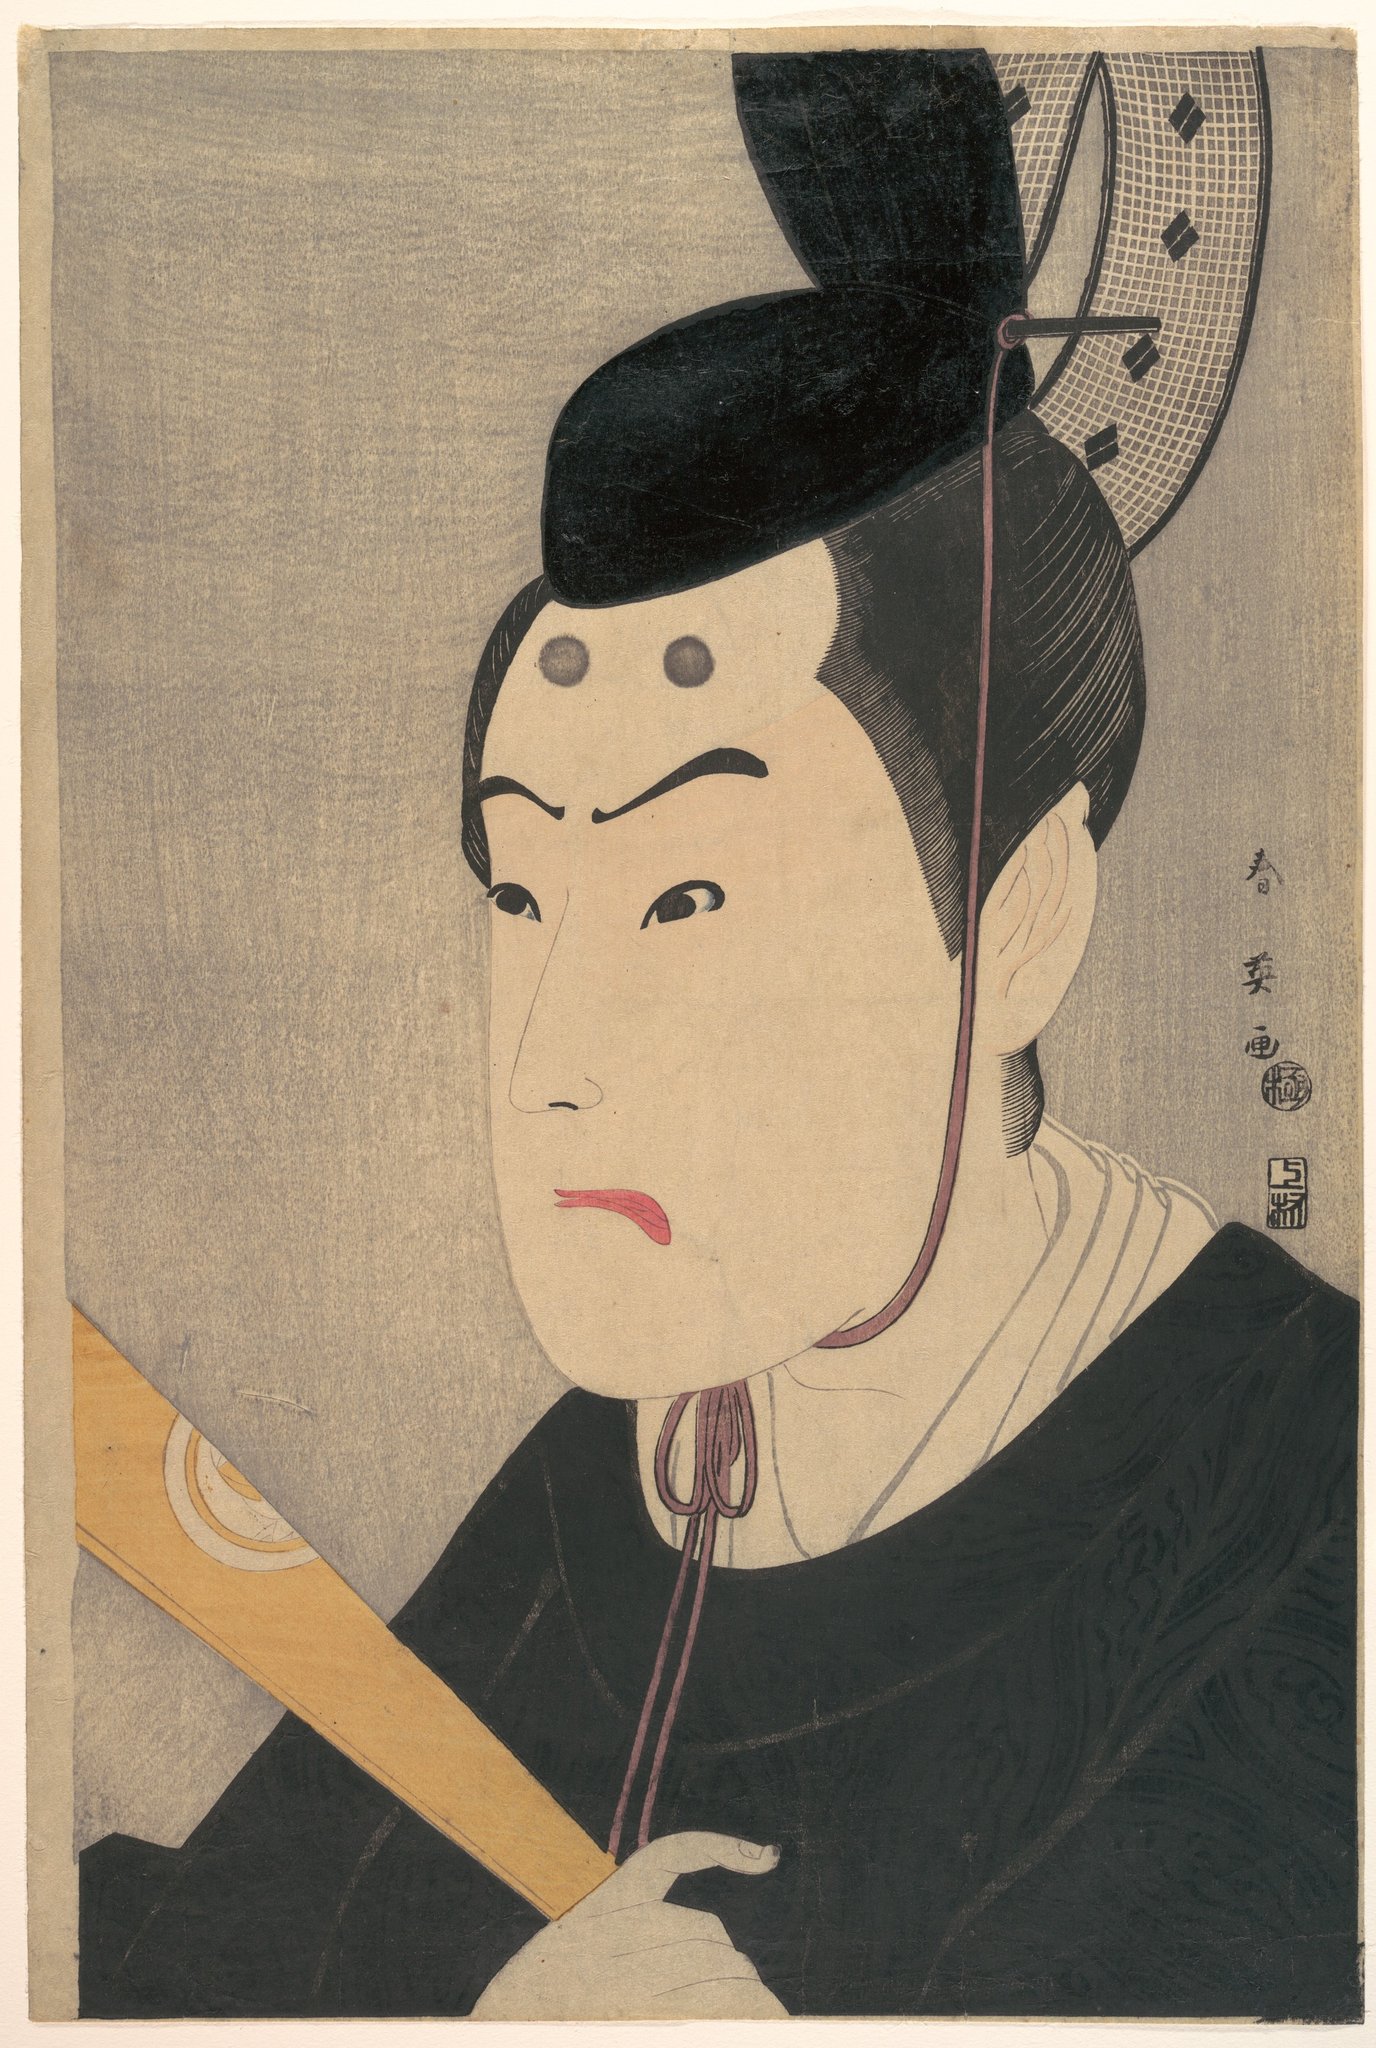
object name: print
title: Bando Hikosaburo III as Sugawara no Michizane, from the Kabuki play, "Sugawara's Secrets of Calligraphy" (Sugawara Denju Tenarai Kagami)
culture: japanese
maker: katsukawa shun'ei 勝川春英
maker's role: artist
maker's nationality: japanese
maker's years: 1762-1819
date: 1800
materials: ink, paper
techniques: woodblock print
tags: men,actors